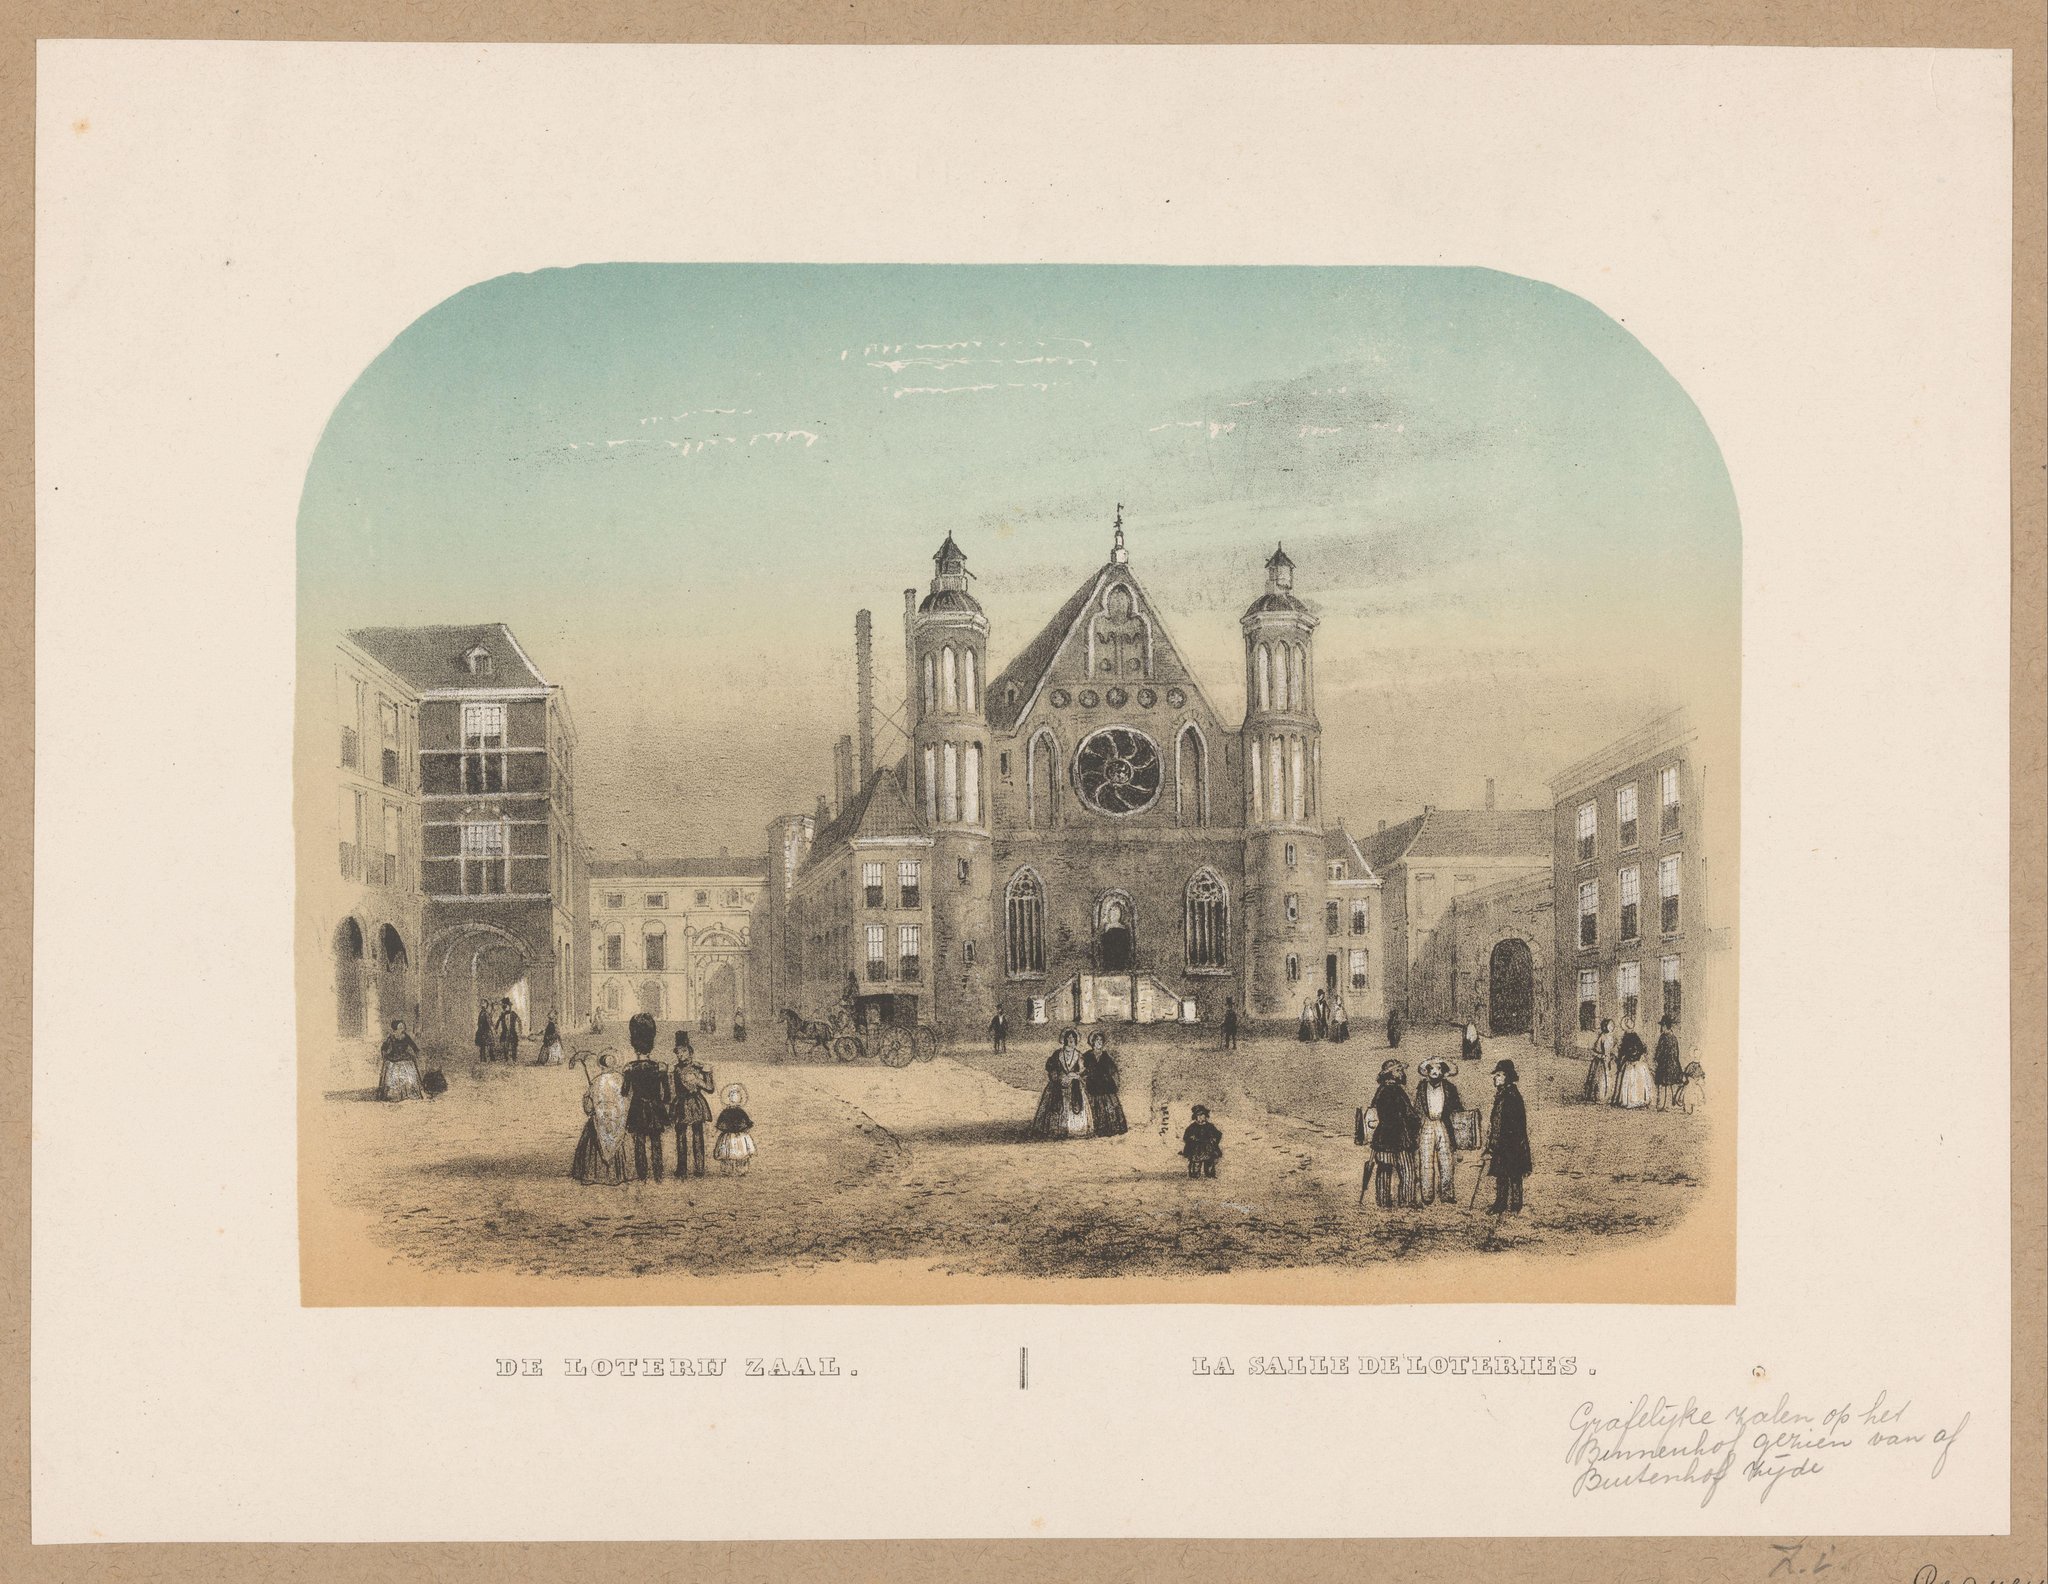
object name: print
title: De loterij zaal / La salle de loteries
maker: Anonymous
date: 1840-1860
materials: paper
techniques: iris print, lithograph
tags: city-view, and landscape with man-made constructions, the hague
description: Gezicht op de Loterijzaal, de huidige Ridderzaal.